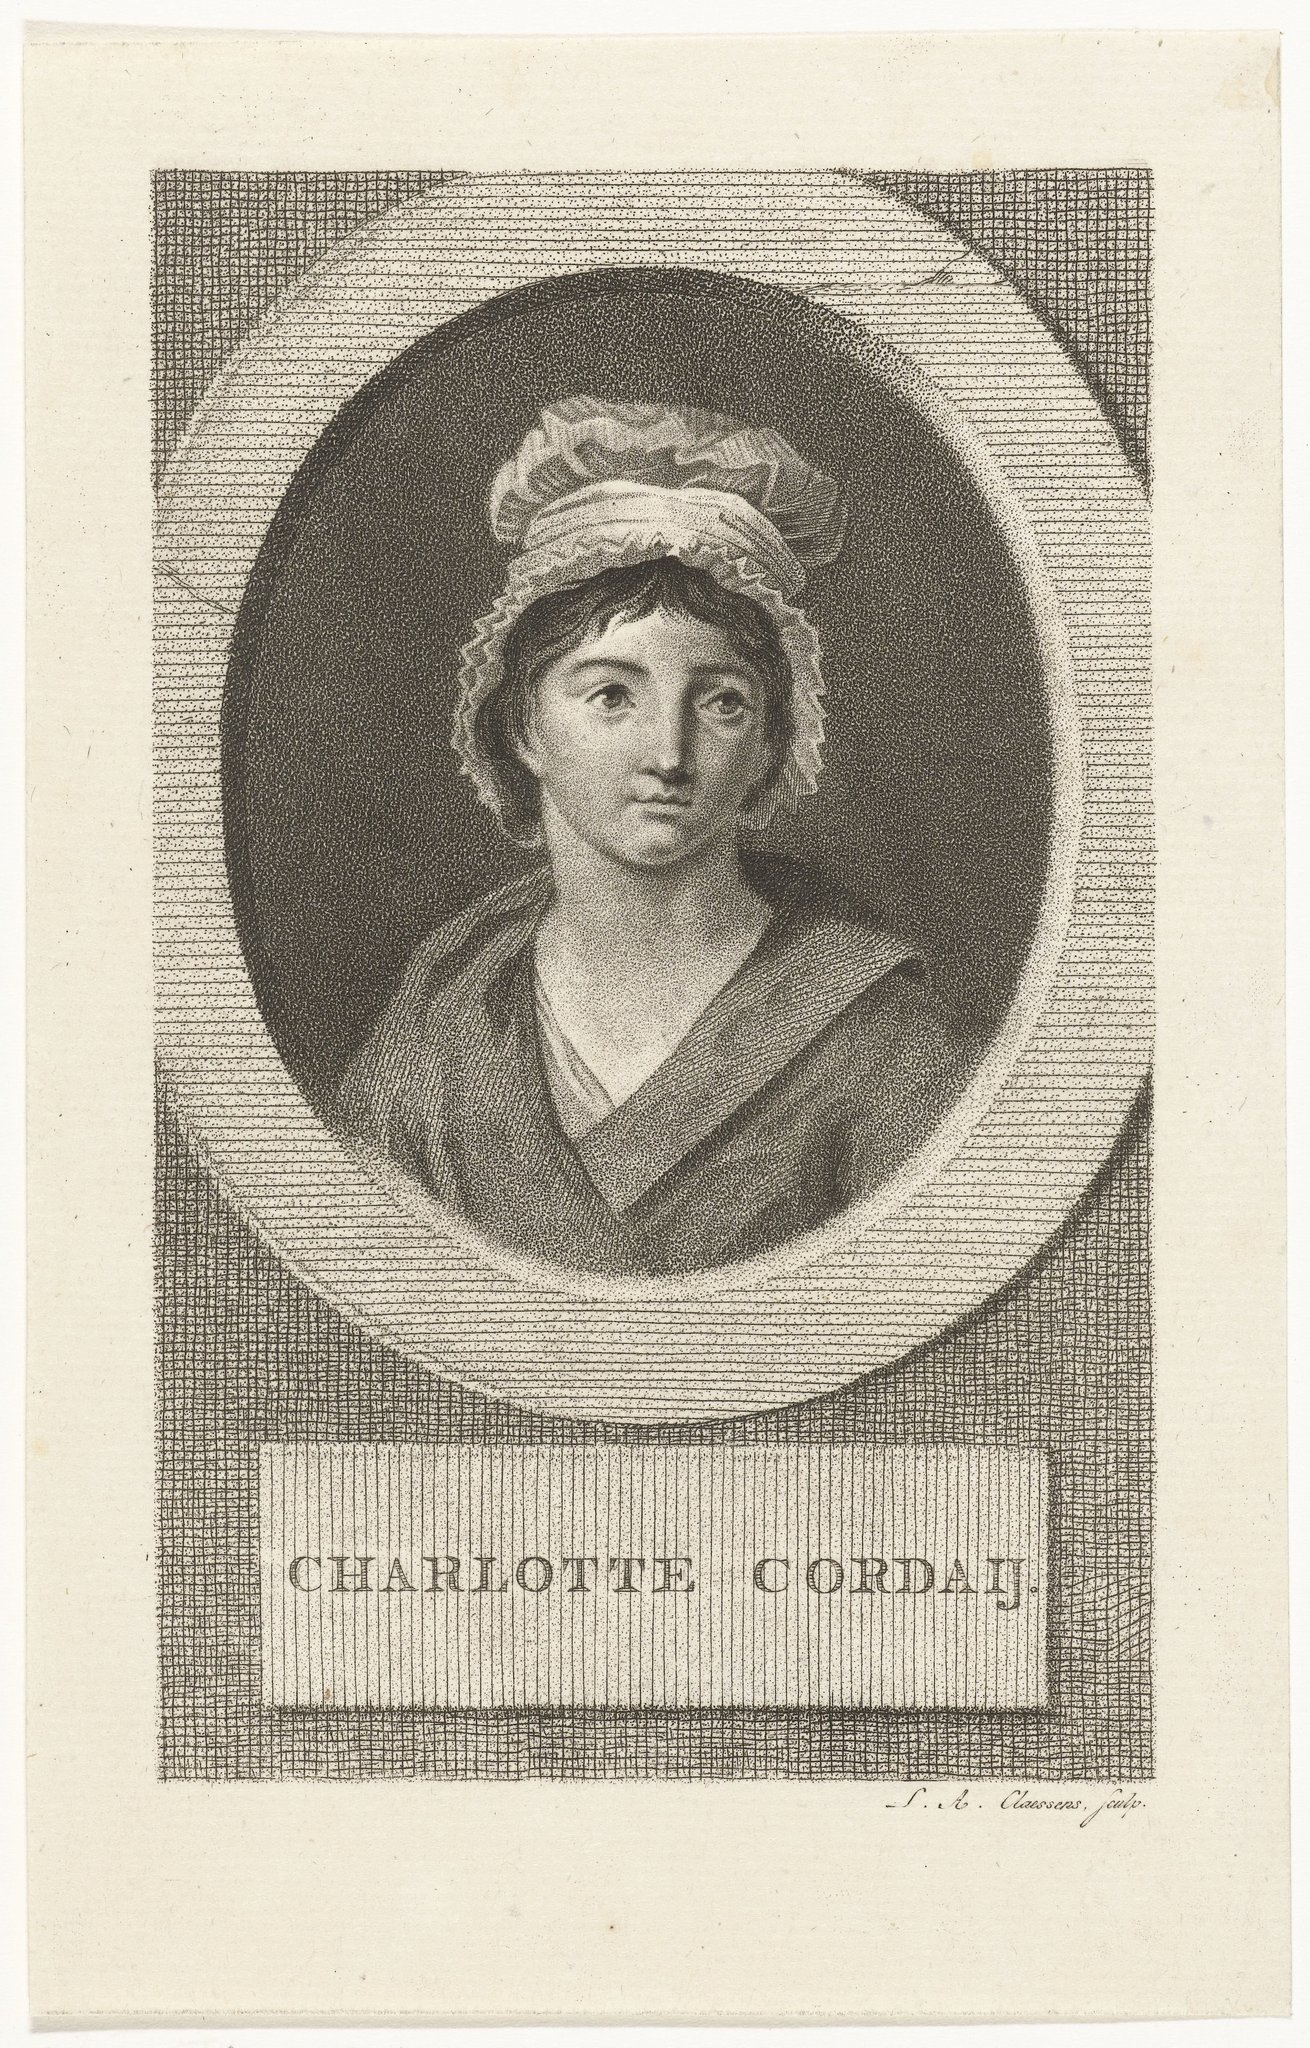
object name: print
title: Portret van Charlotte Corday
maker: lambertus antonius claessens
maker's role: draughtsman, print maker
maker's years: 1763-1834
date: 1792-1808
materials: paper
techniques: engraving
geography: amsterdam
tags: paris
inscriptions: collector's mark: Lugt 2228